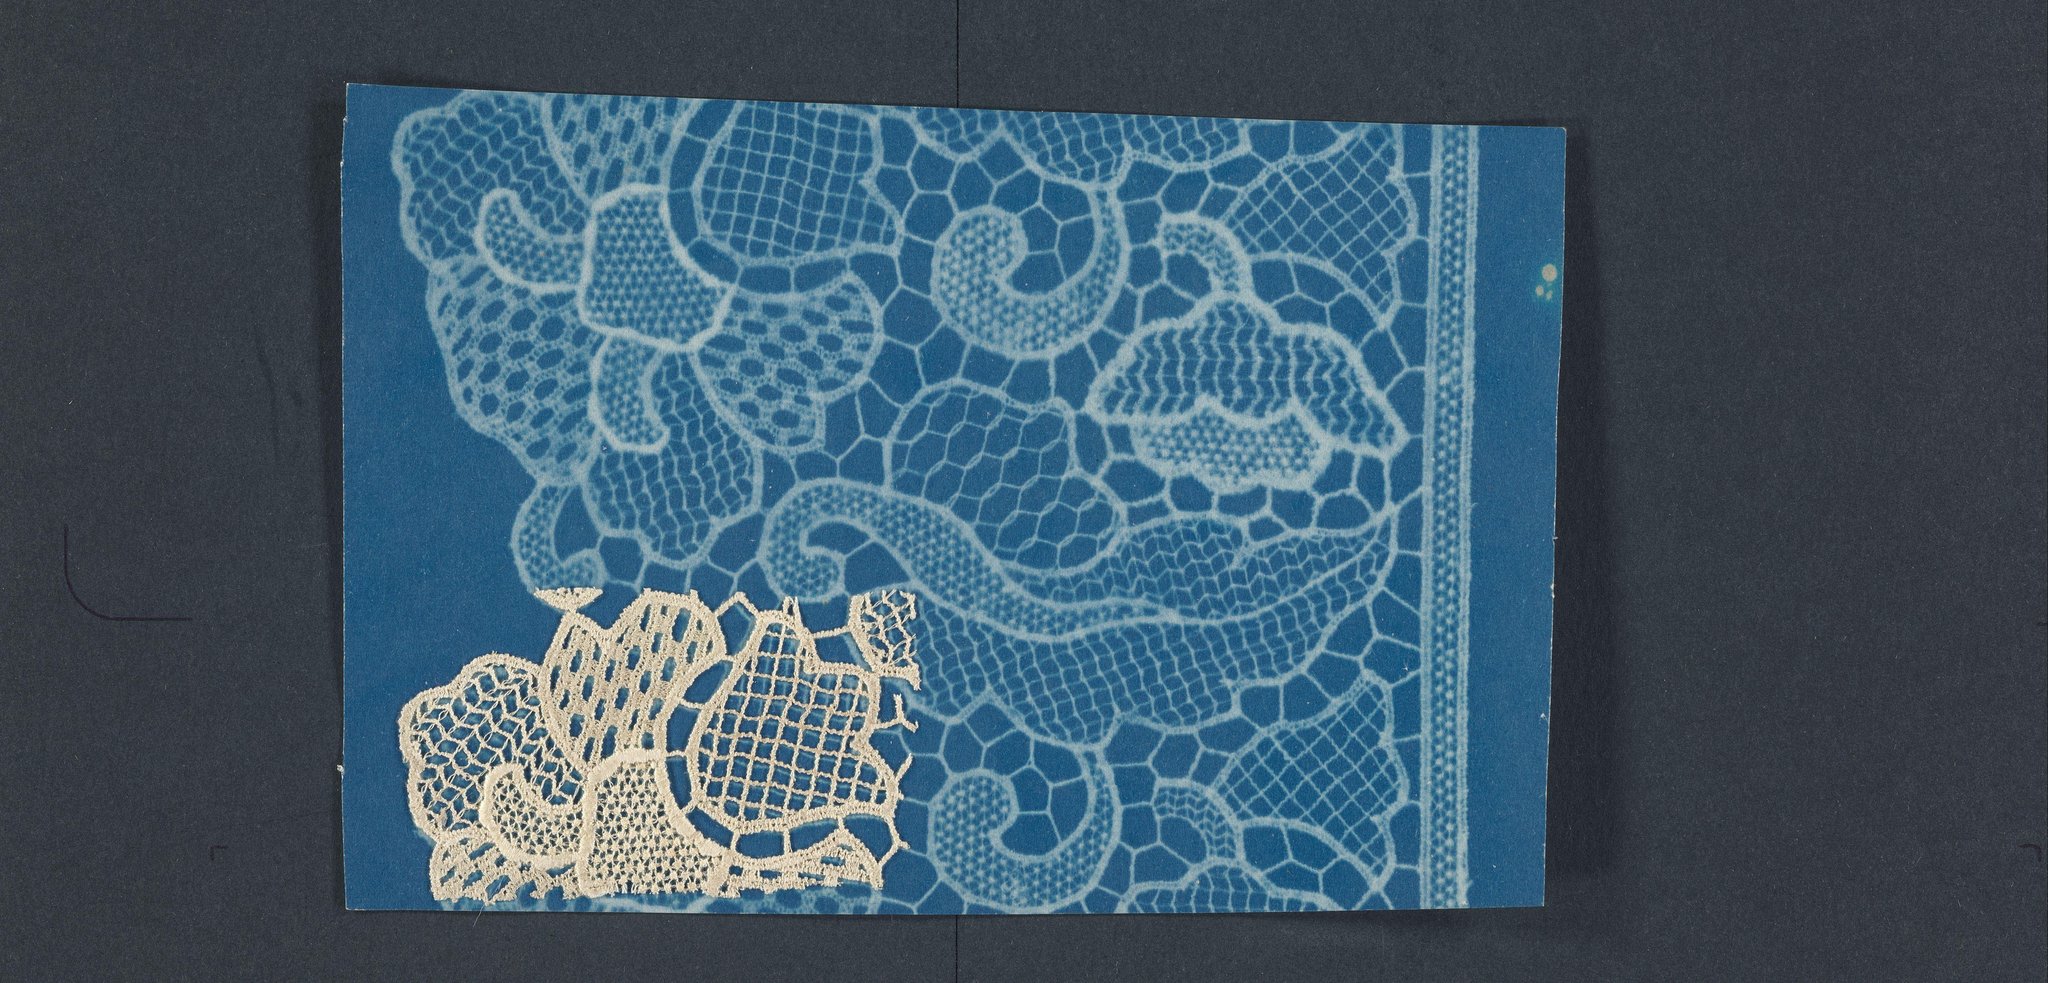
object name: photogram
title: Kant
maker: Anonymous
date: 1900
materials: paper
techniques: cyanotype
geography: france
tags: lace